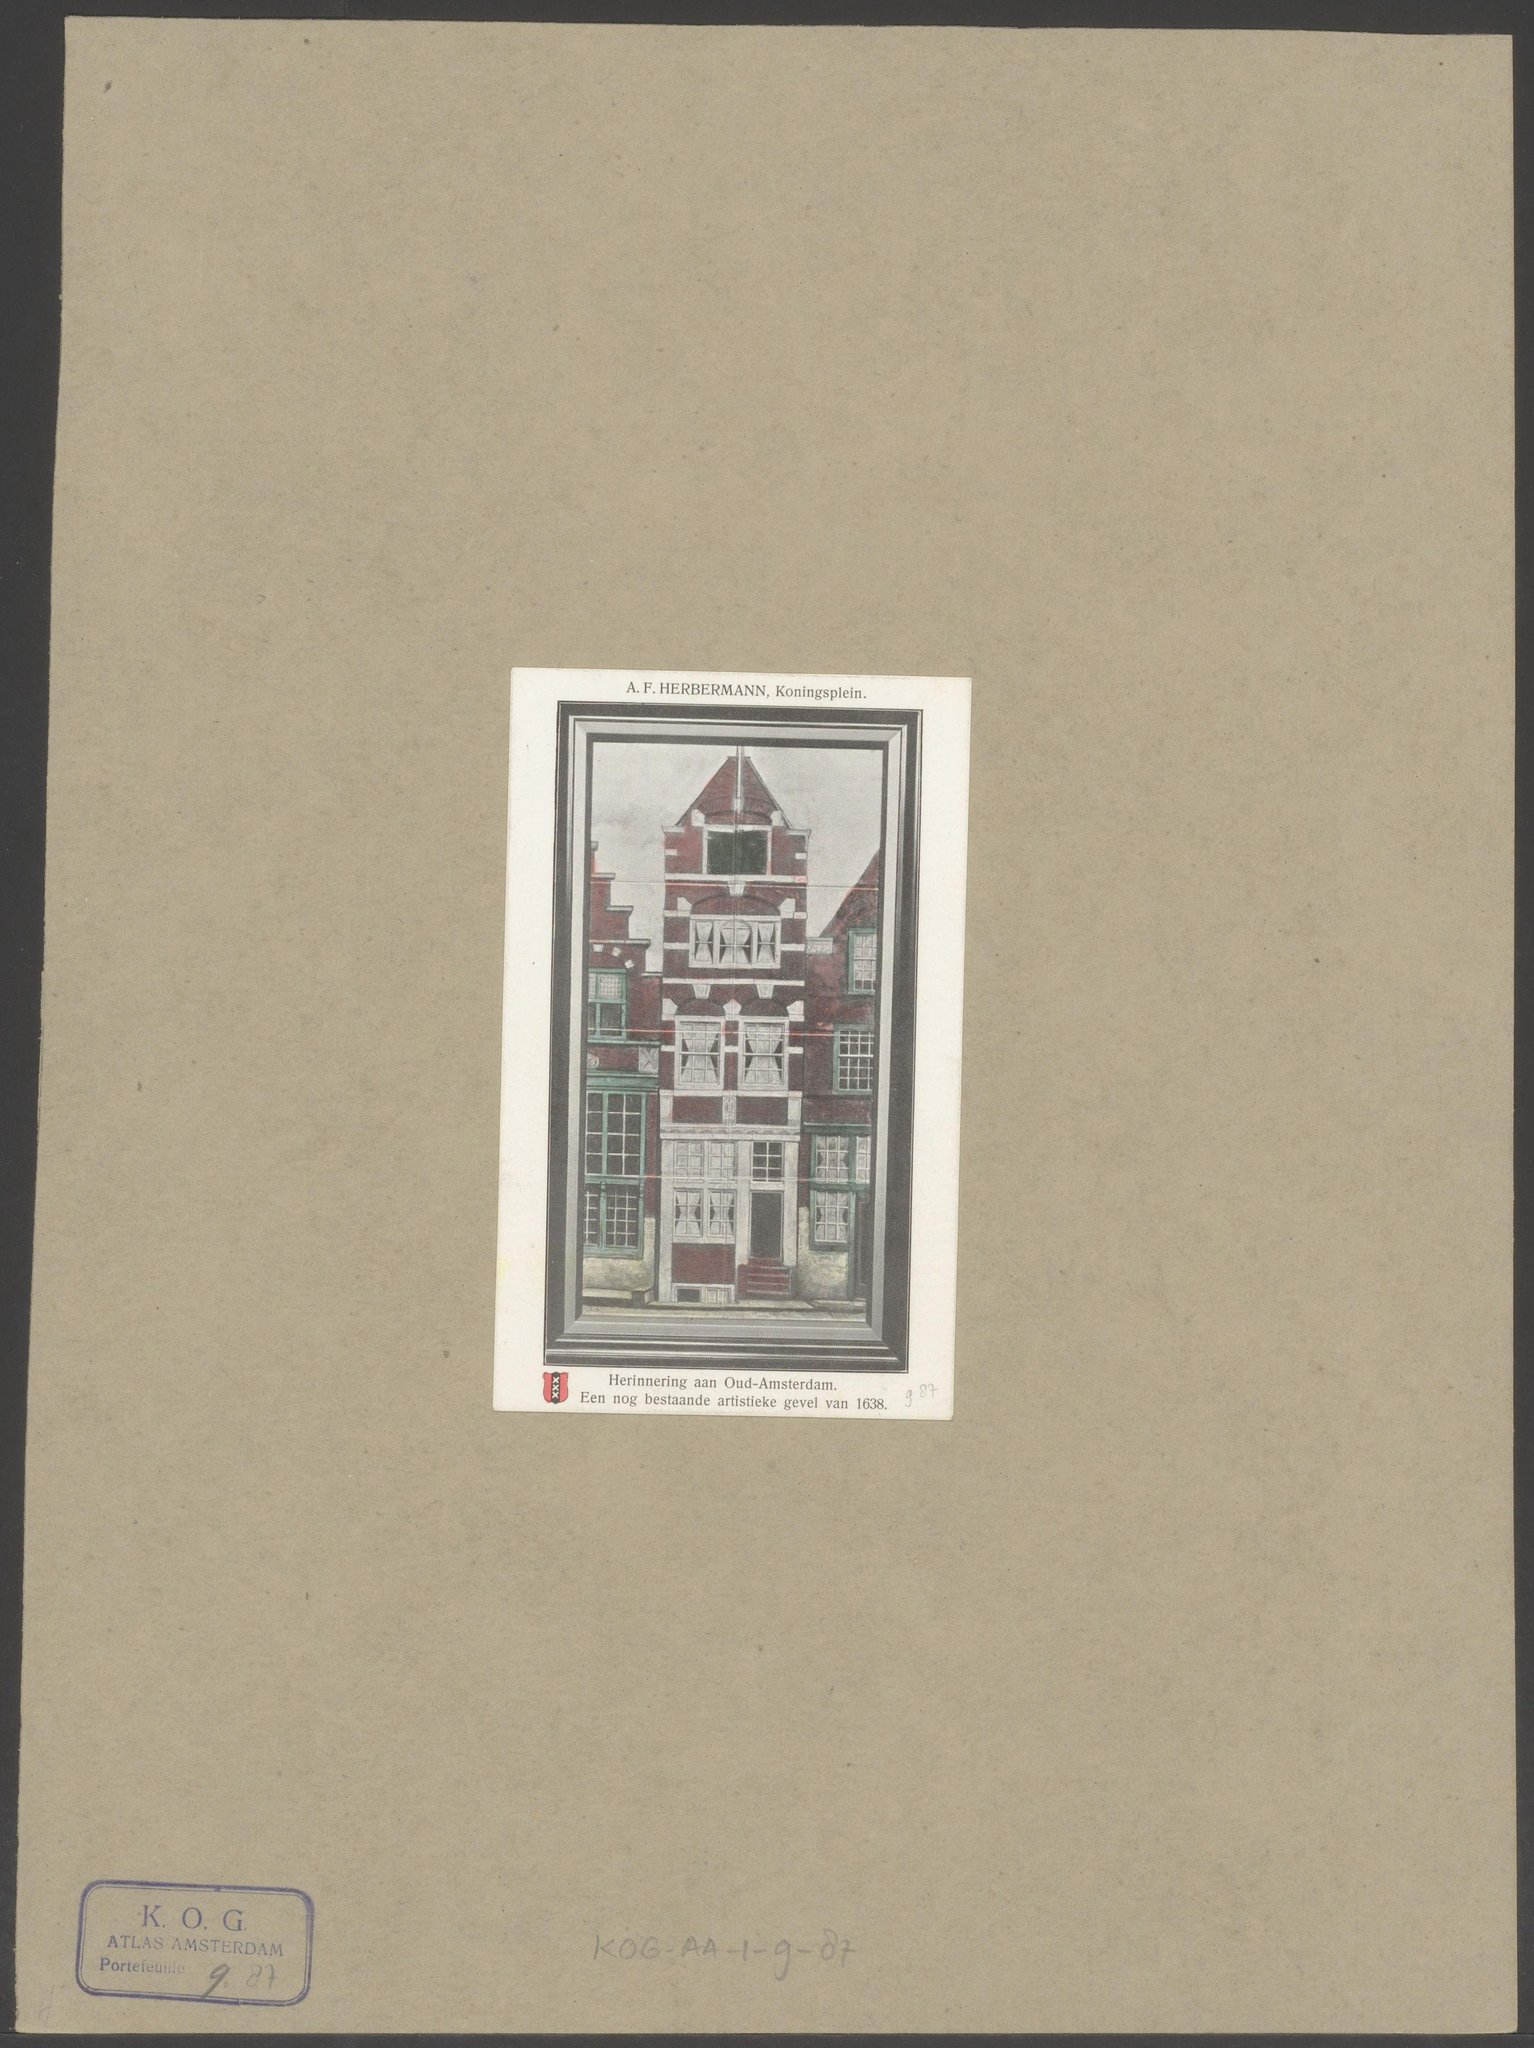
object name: cabinet photograph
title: Gezicht op een gevel van een pand aan het Koningsplein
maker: Anonymous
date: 1882-1950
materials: paper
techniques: hand coloring, letterpress printing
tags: city-view in general; 'veduta', façade (of house or building)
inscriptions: collector's mark: ‘9.87’ Lugt 1641b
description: Onderwerpsrubriek binnen de Atlas Amsterdam: Kadijksplein, Karthuizerkerkhof, Kattegat, Kattenburg, Kapelsteeg O.Z., Enge Kerksteeg, Kerkstraat, Kinkerstraat, Kolk O.Z., Koningsplein, Kromboomsloot [Krom Boomssloot], Kostverlorenkade, Kwakersdwarspad, Kalverstraat, Keizersgracht (v.d. Brouwersgracht – Amstel), Klerensloot (Gedempte), Klimopstraat, Kloveniersburgwal, Kraansluis.